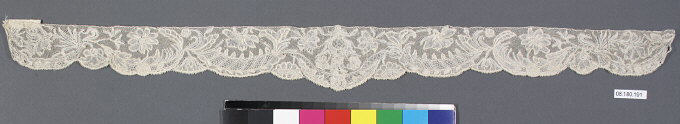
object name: piece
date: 1701-1800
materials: lace